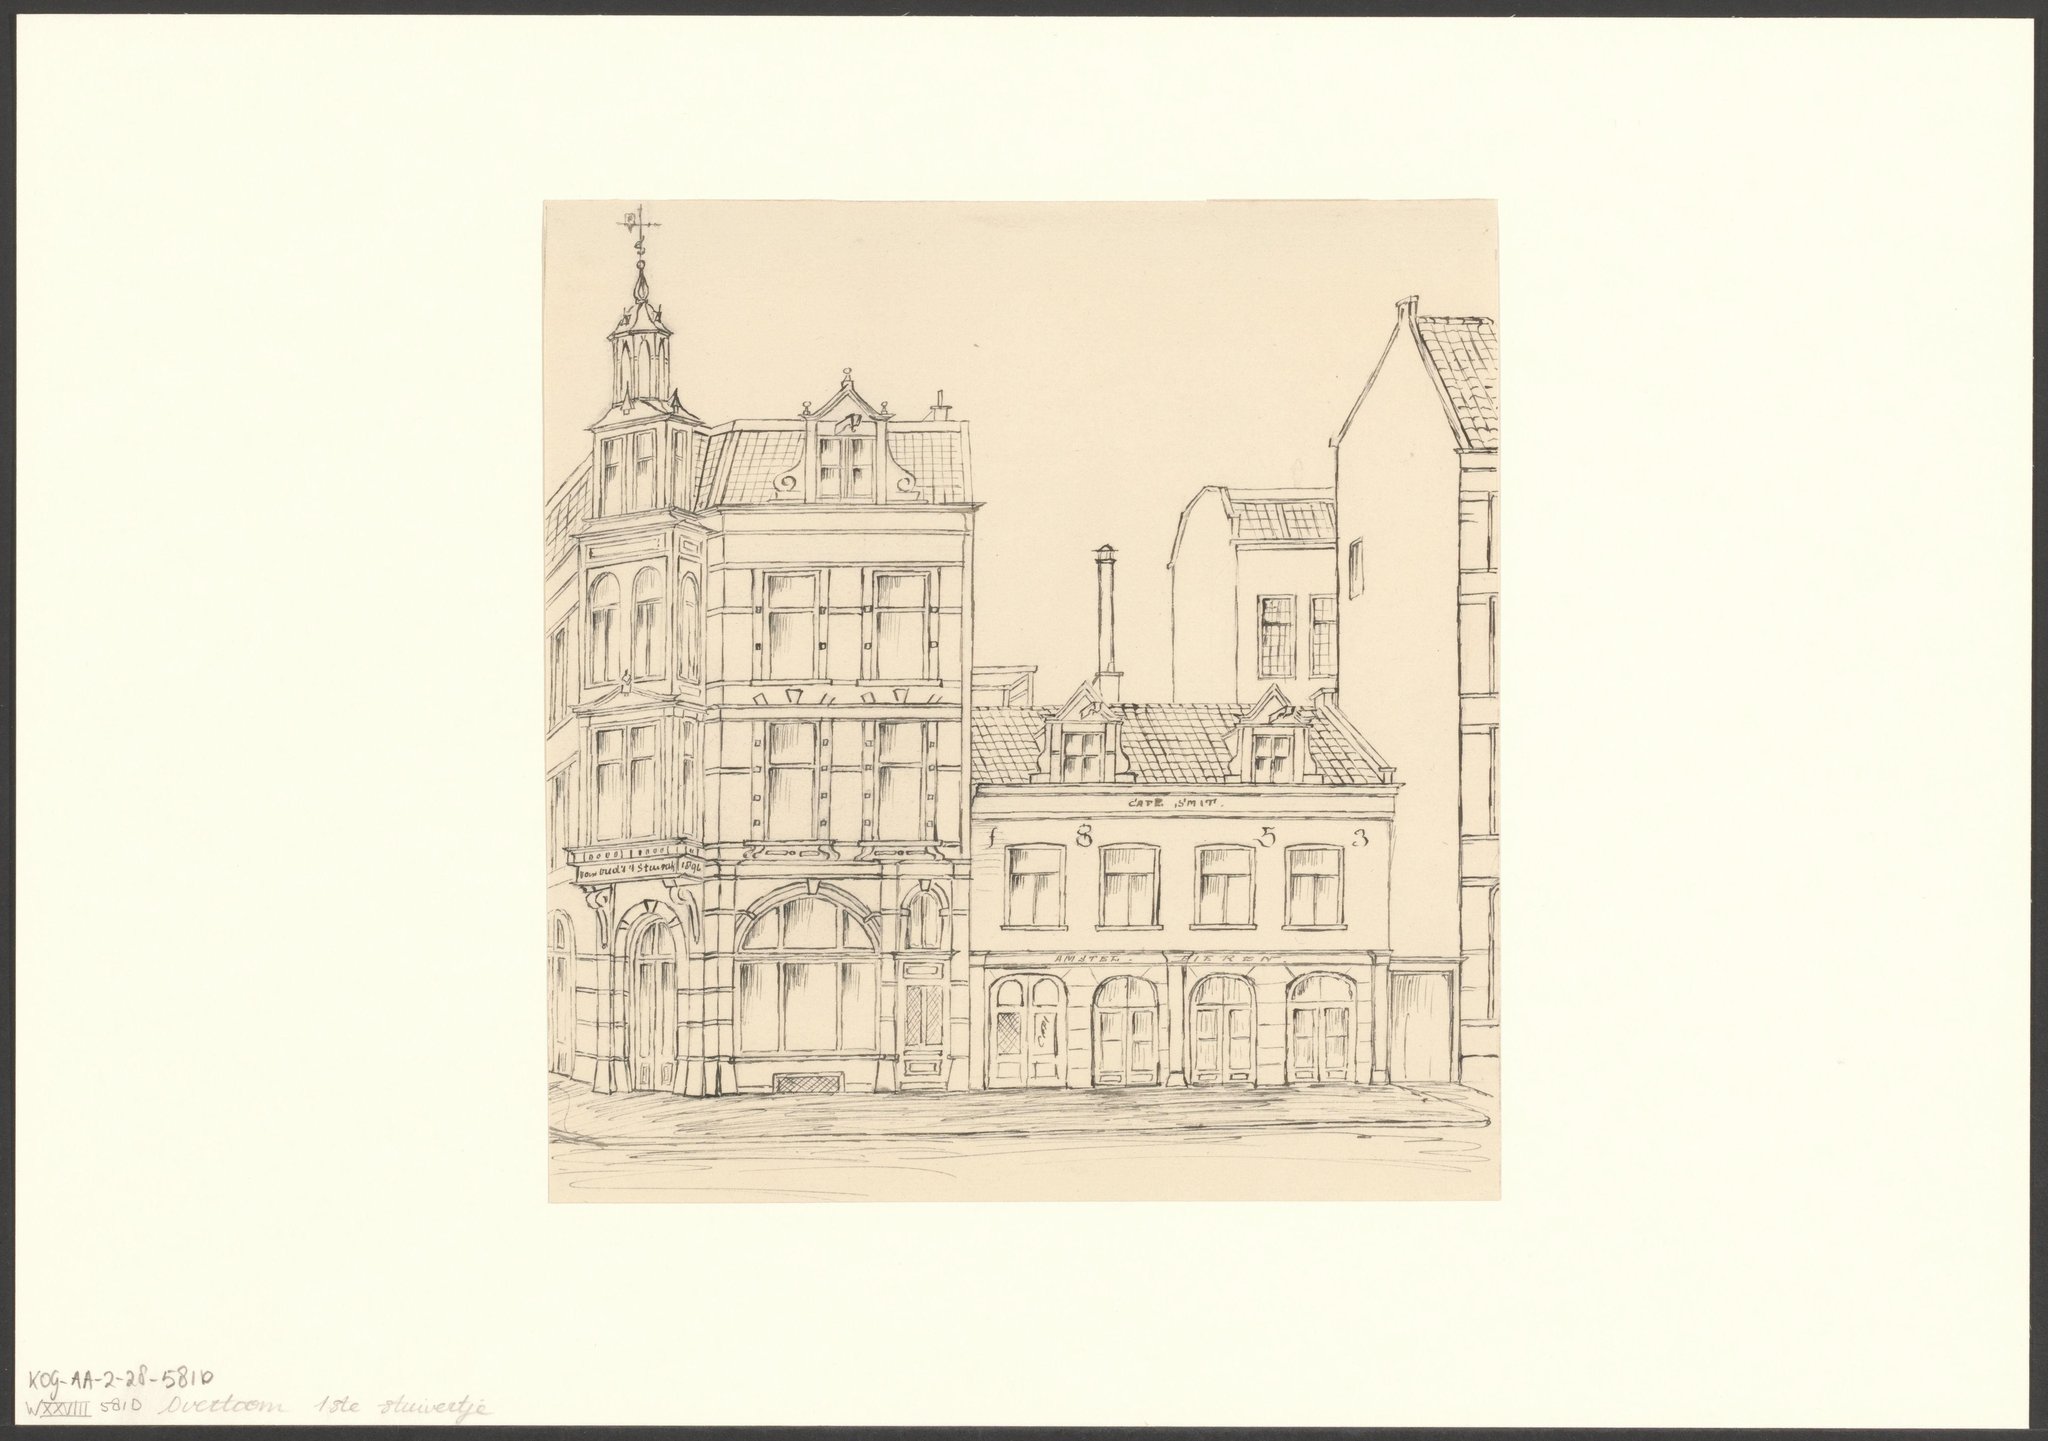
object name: drawing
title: Gezicht op herberg Het Eerste Stuivertje aan de Overtoom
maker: Anonymous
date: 1896-1950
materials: ink, paper, pencil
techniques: pen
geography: amsterdam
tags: city-view in general; 'veduta', façade (of house or building), hotel, hostelry, inn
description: Tekening binnen de Atlas Van Eck ingedeeld op wijknummer 28.